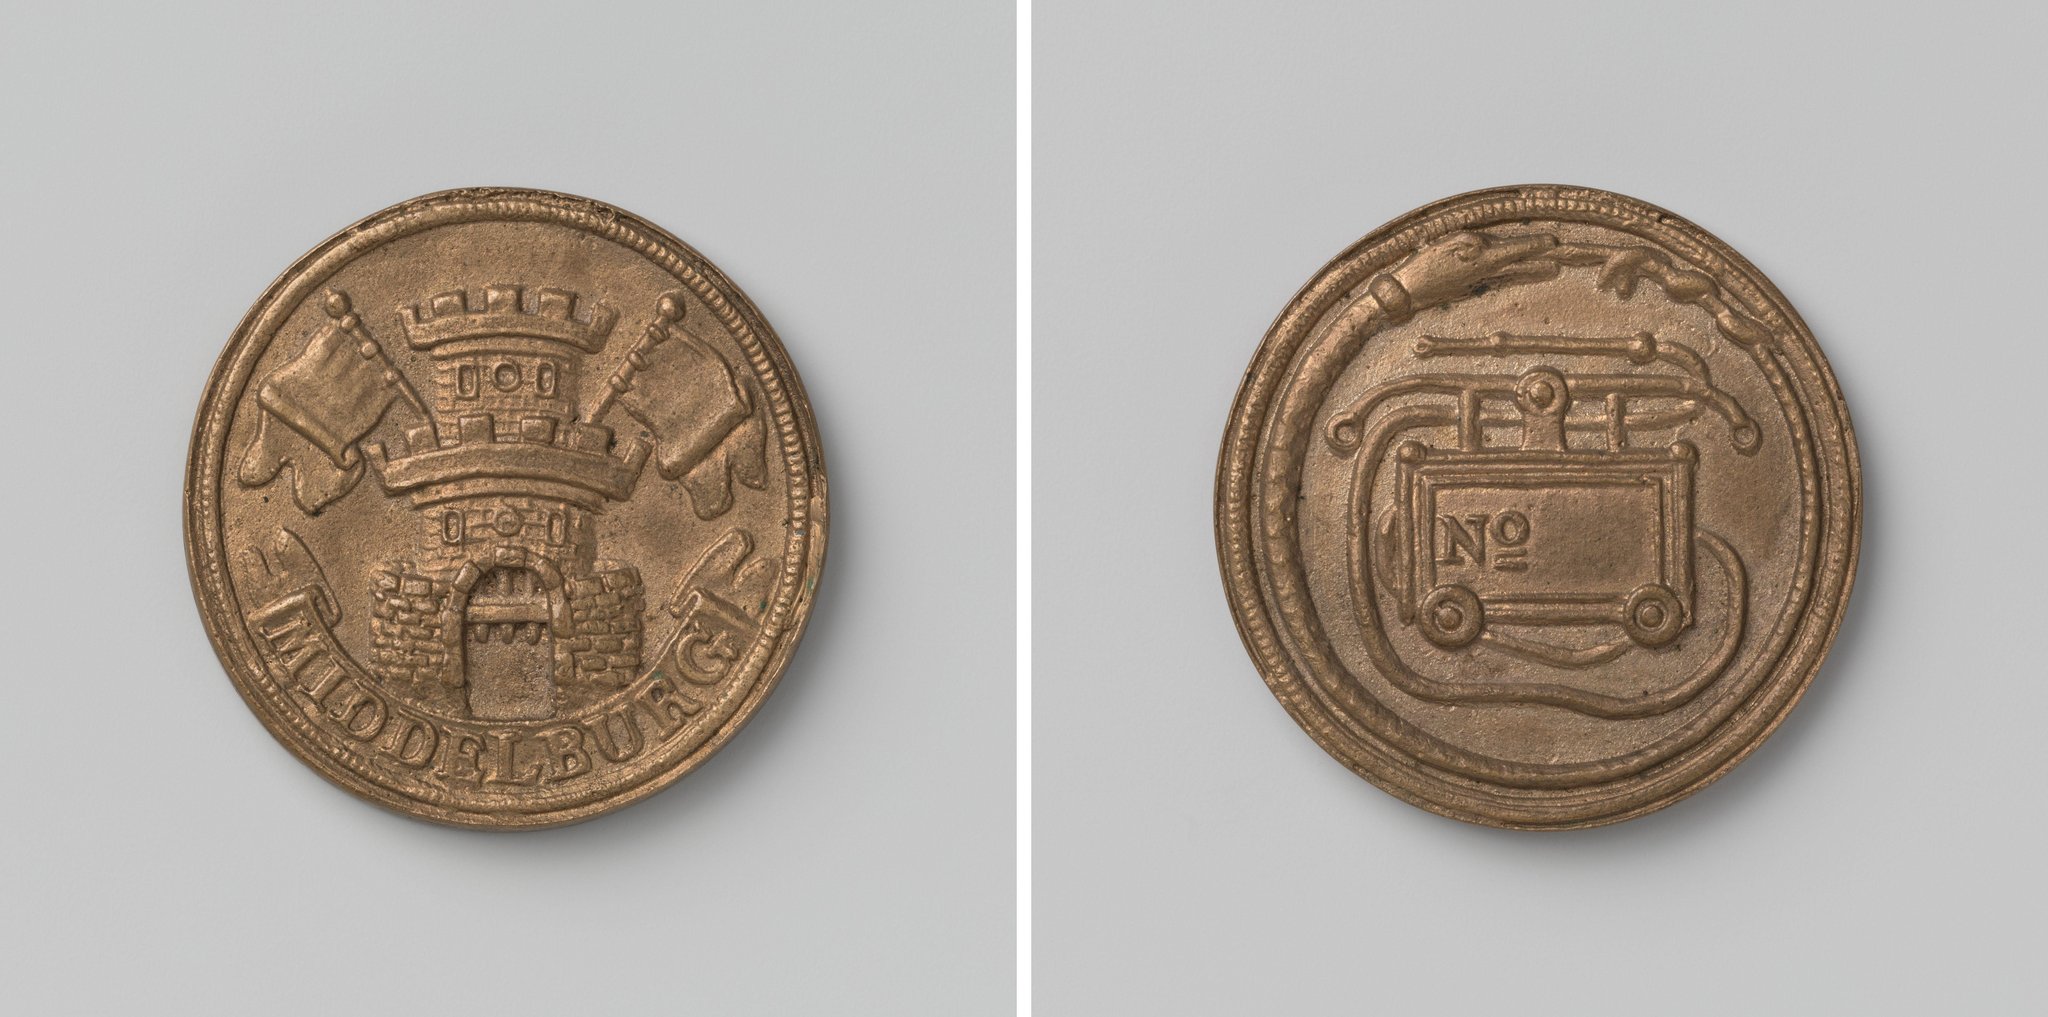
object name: medal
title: Middelburg, brandspuitpenning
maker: Anonymous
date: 1680-1800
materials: brass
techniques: casting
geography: middelburg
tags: middelburg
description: Messing penning. Voorzijde: burcht, waaraan twee vaandels hangen. Keerzijde: brandspuit binnen slangerond; op zijde van brandspuit: opschrift No.